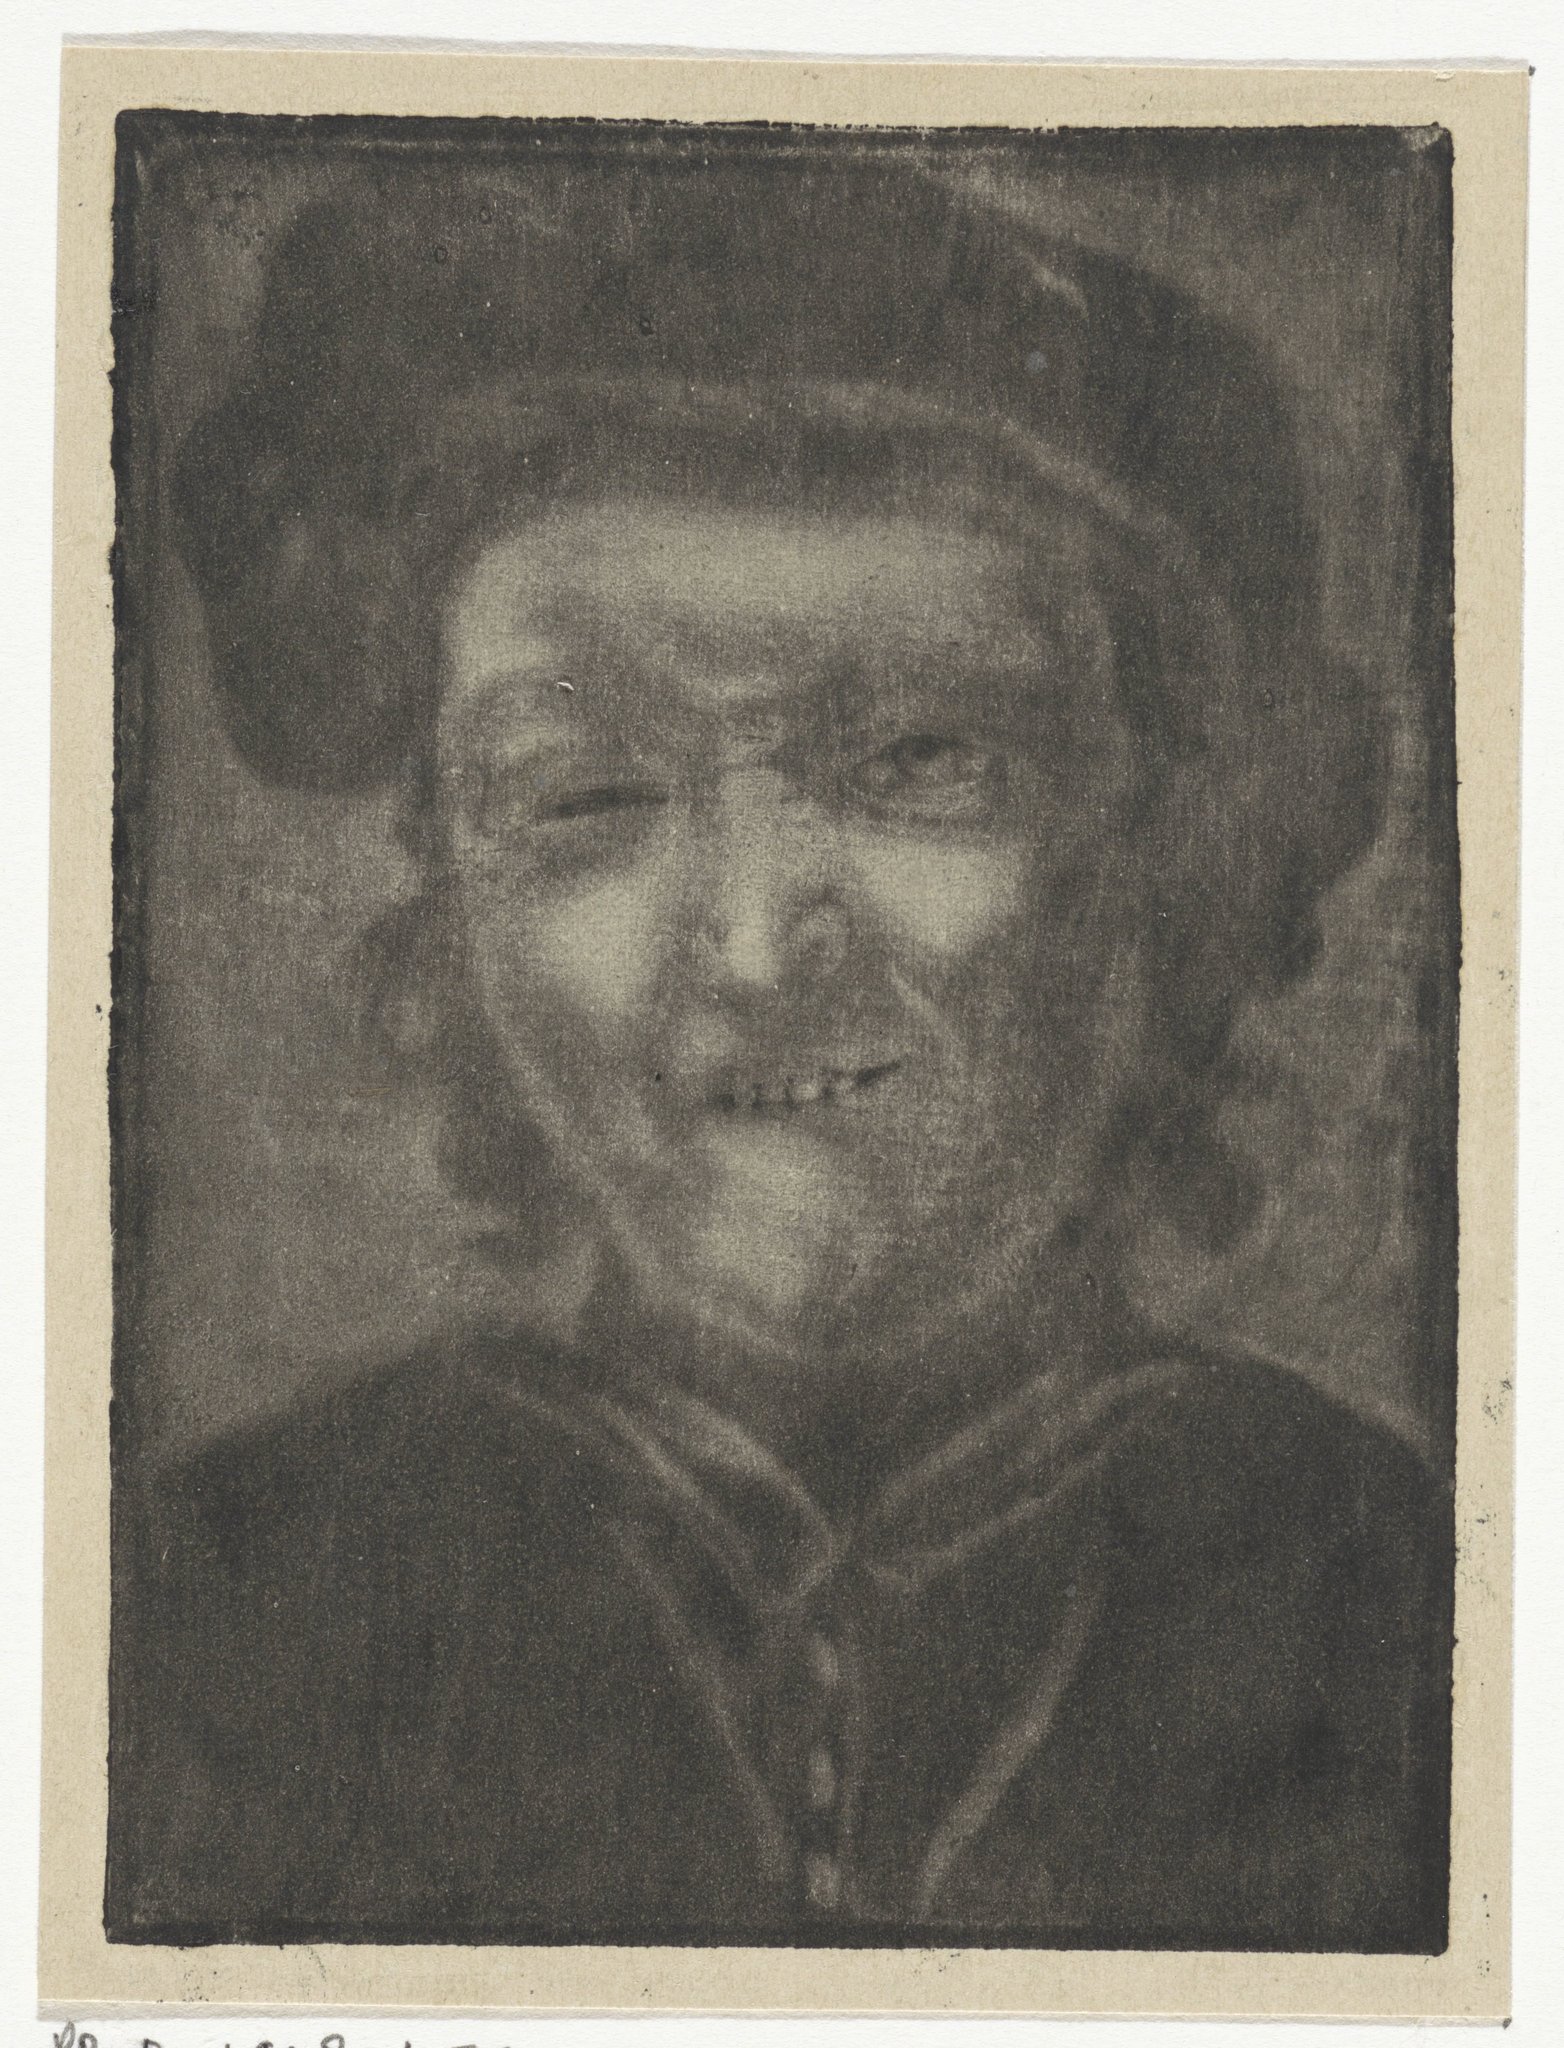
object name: print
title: Man met een vertrokken gezicht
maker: eberhard cornelis rahms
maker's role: print maker, publisher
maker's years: 1823-1907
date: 1854-1907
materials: paper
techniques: mezzotint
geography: netherlands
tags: head-gear: cap (+ men's clothes), grimacing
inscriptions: collector's mark: Lugt 2228